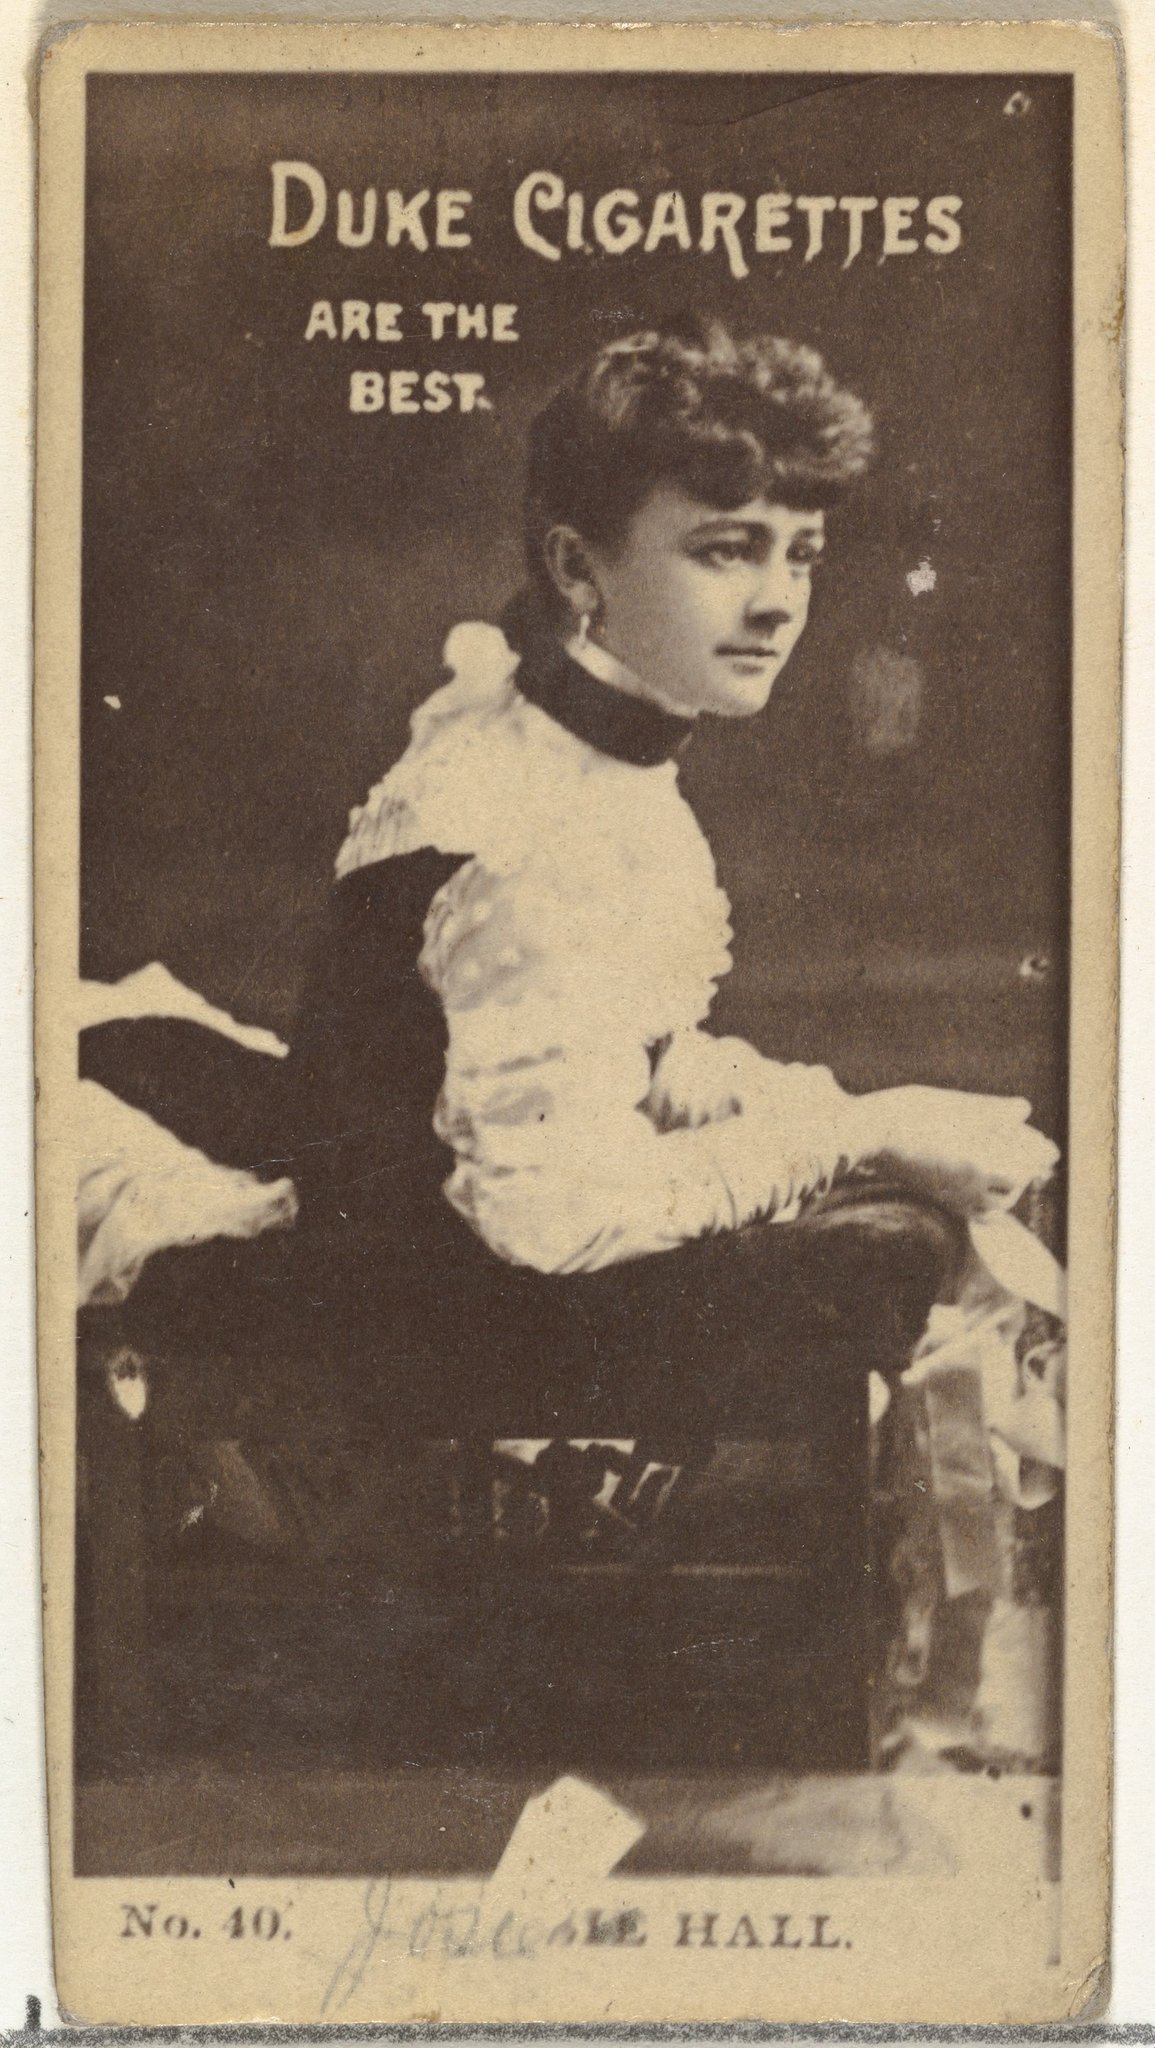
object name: photograph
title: Card Number 40, Miss Hall, from the Actors and Actresses series (N145-6) issued by Duke Sons & Co. to promote Duke Cigarettes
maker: w. duke, sons & co.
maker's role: publisher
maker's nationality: american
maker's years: 1870-1920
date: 1880-1889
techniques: albumen silver print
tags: portraits,women,actresses